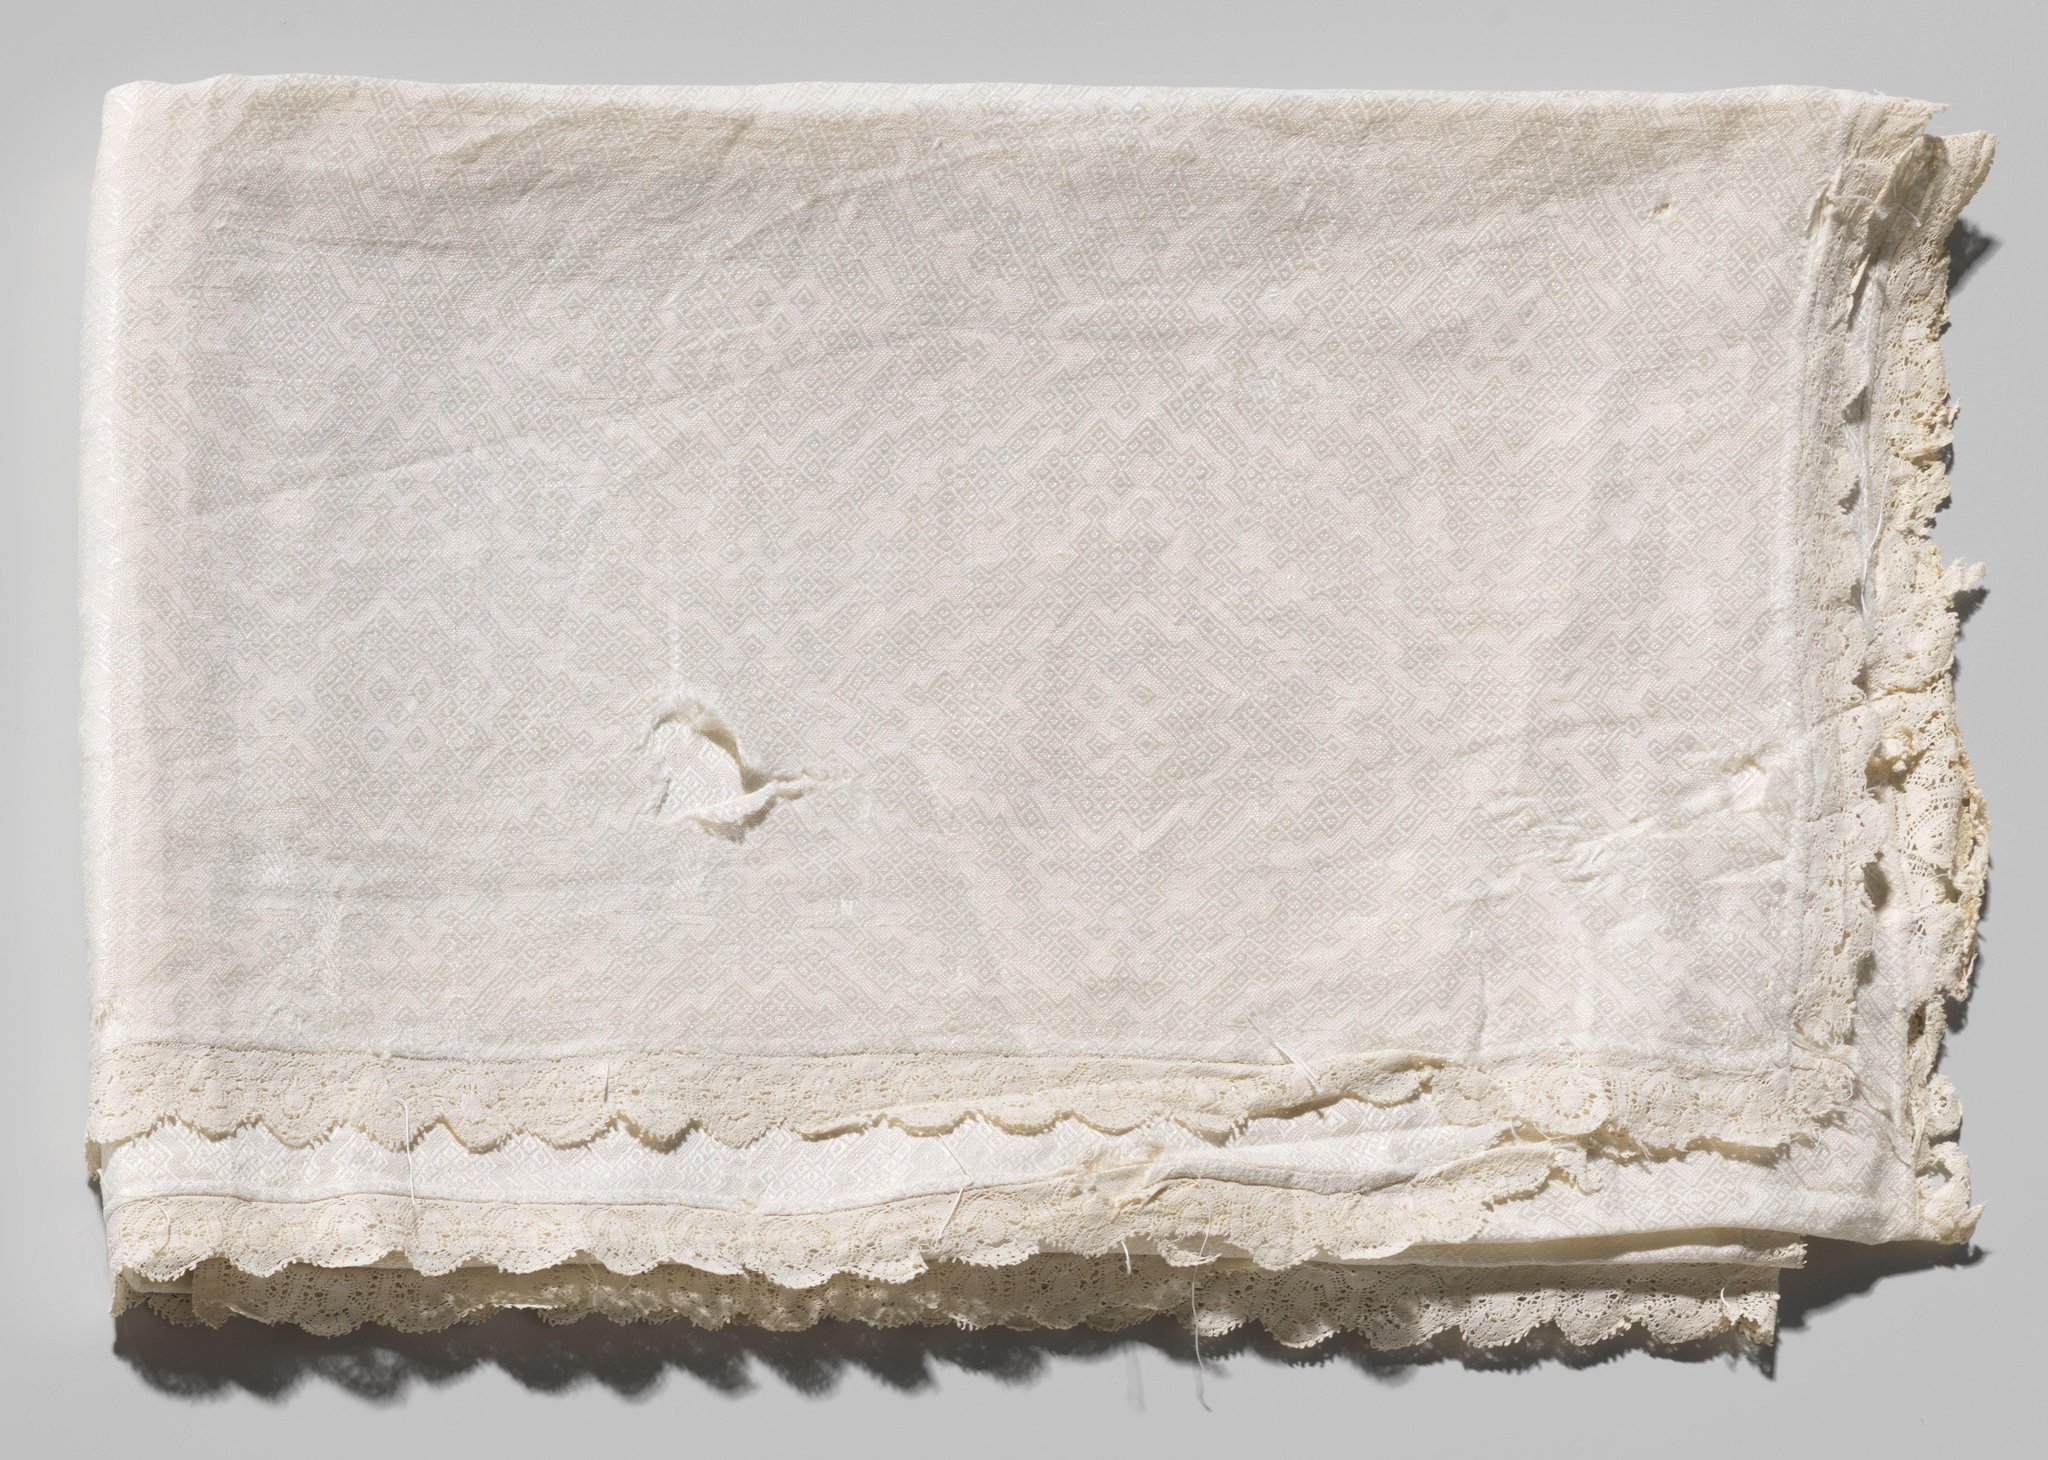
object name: dekservet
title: Servet met groot kruiswerk- en ganzenoogpatroon en langs de randen afgezet met geschulpte kloskant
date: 1690-1710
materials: linen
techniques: lace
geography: netherlands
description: Servet of dekservet van wit linnendamast met twee afgerende hoeken. Patroon: met ganzenoog gevulde banden vormen een groot traliewerk dat zich verdikt en wel: op de snijpunten tot vierkanten, op de zijden tot rechthoeken, die beide trapsgewijs gecontoureerd zijn.